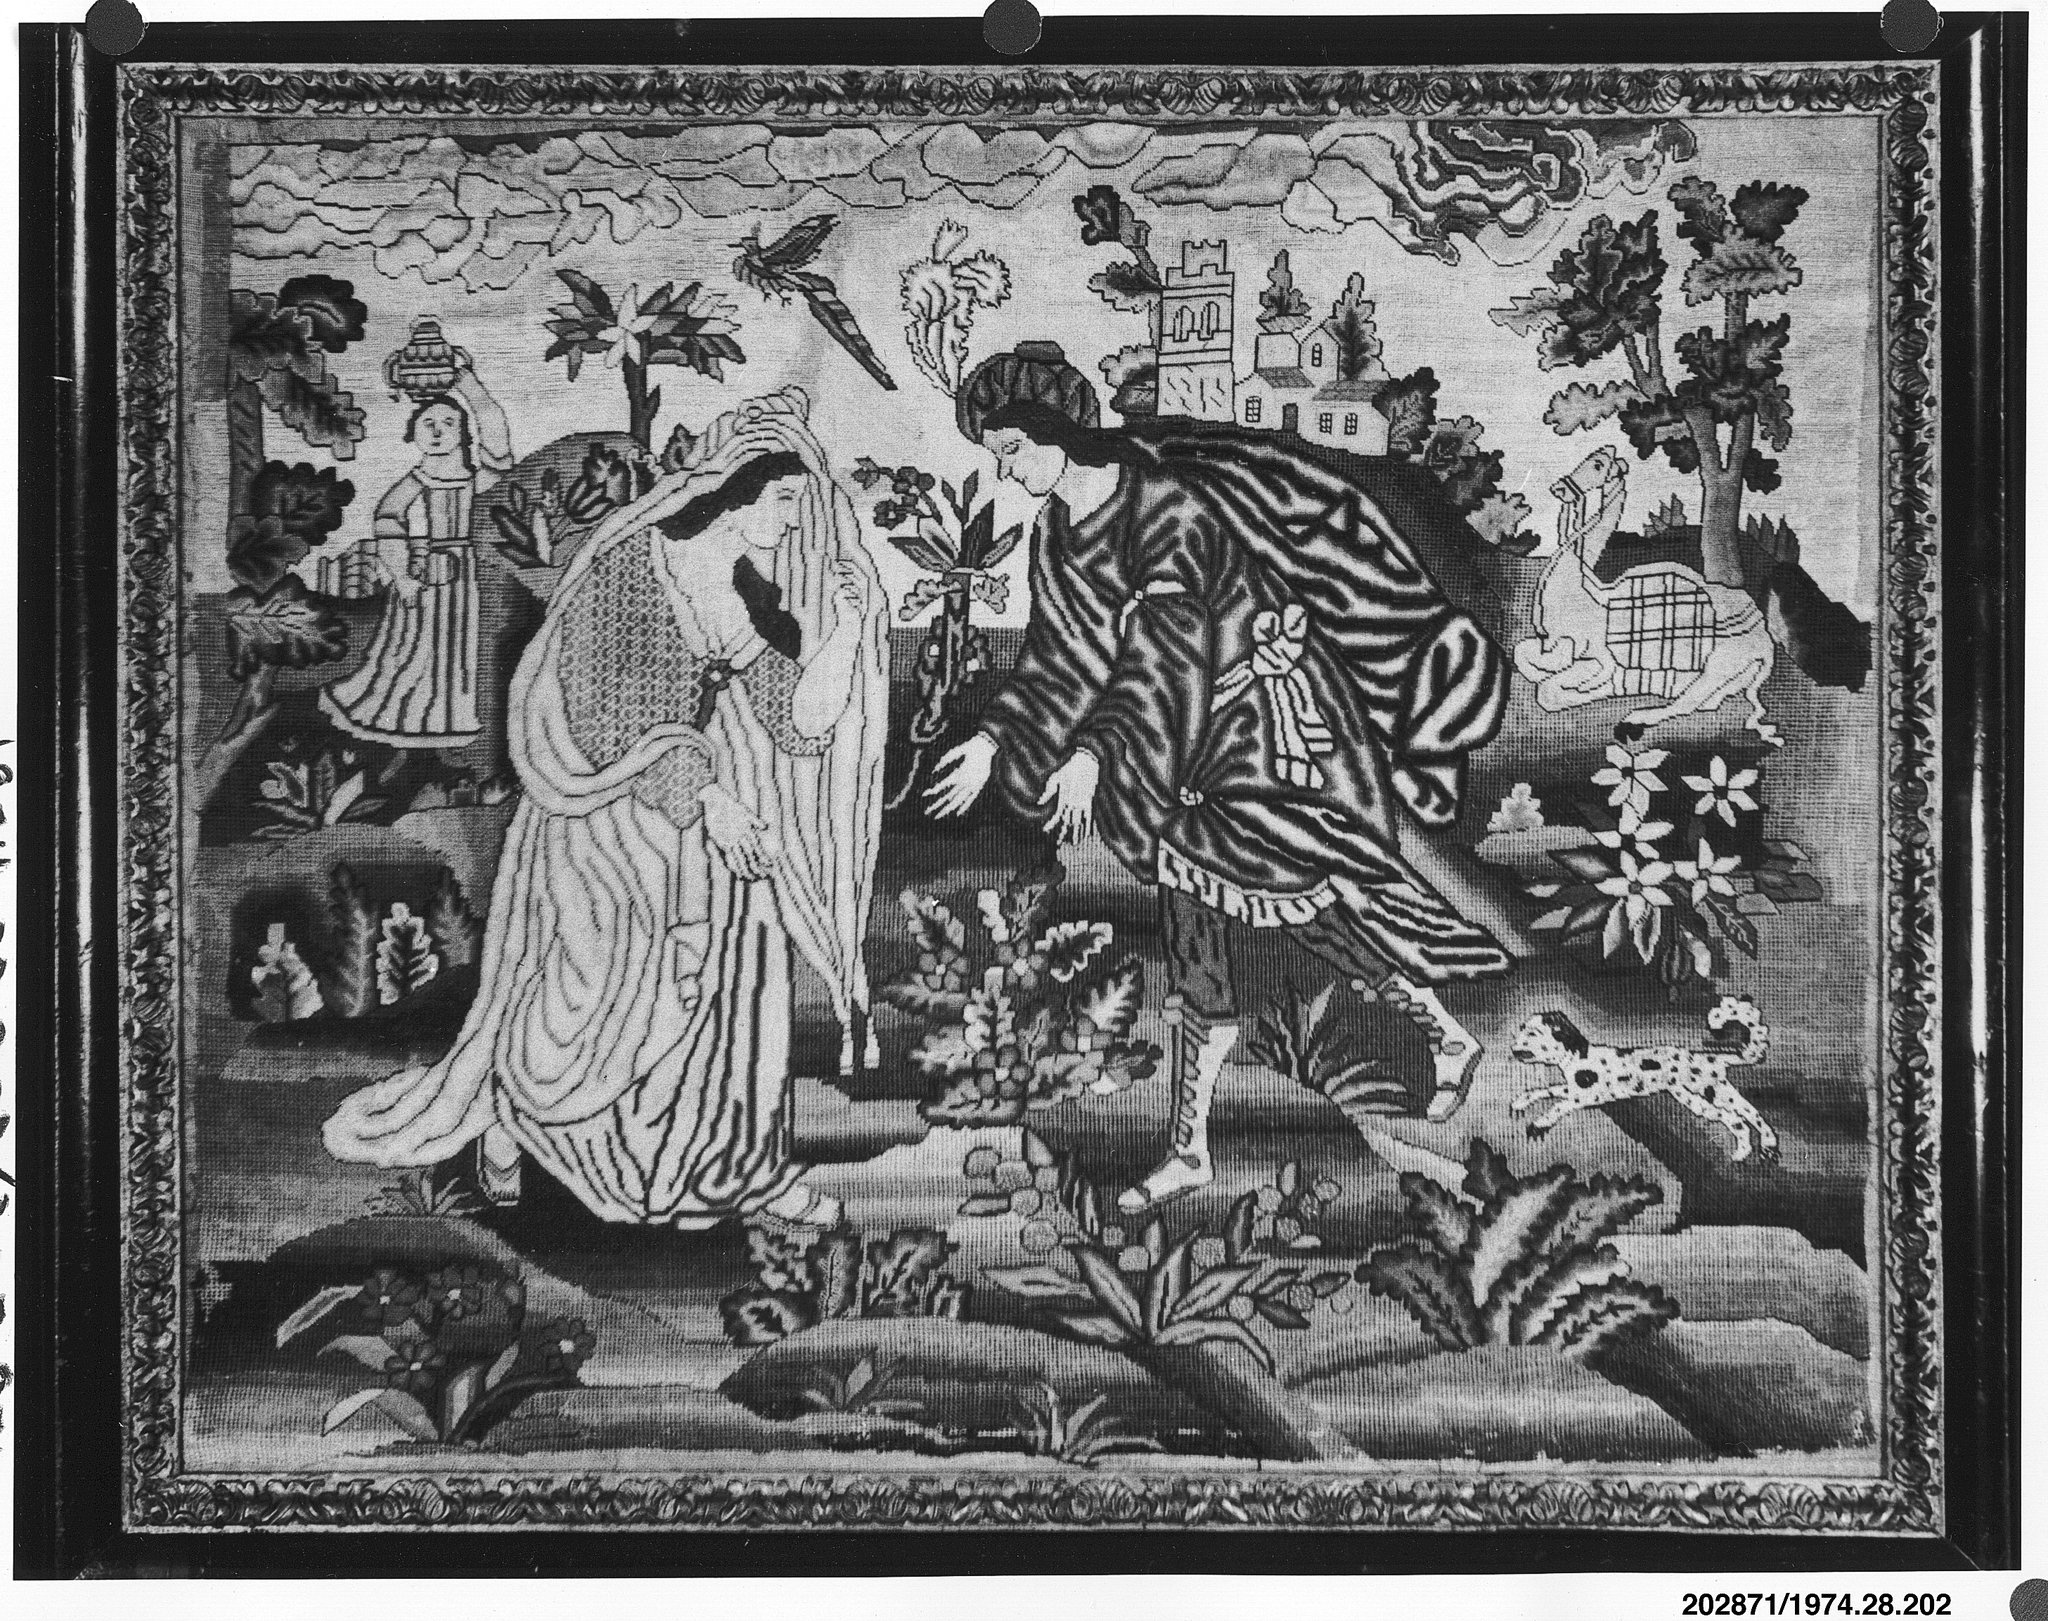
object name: embroidered picture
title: Rebecca at the Well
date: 1700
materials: silk, wool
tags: men,women,camels,dogs,flowers